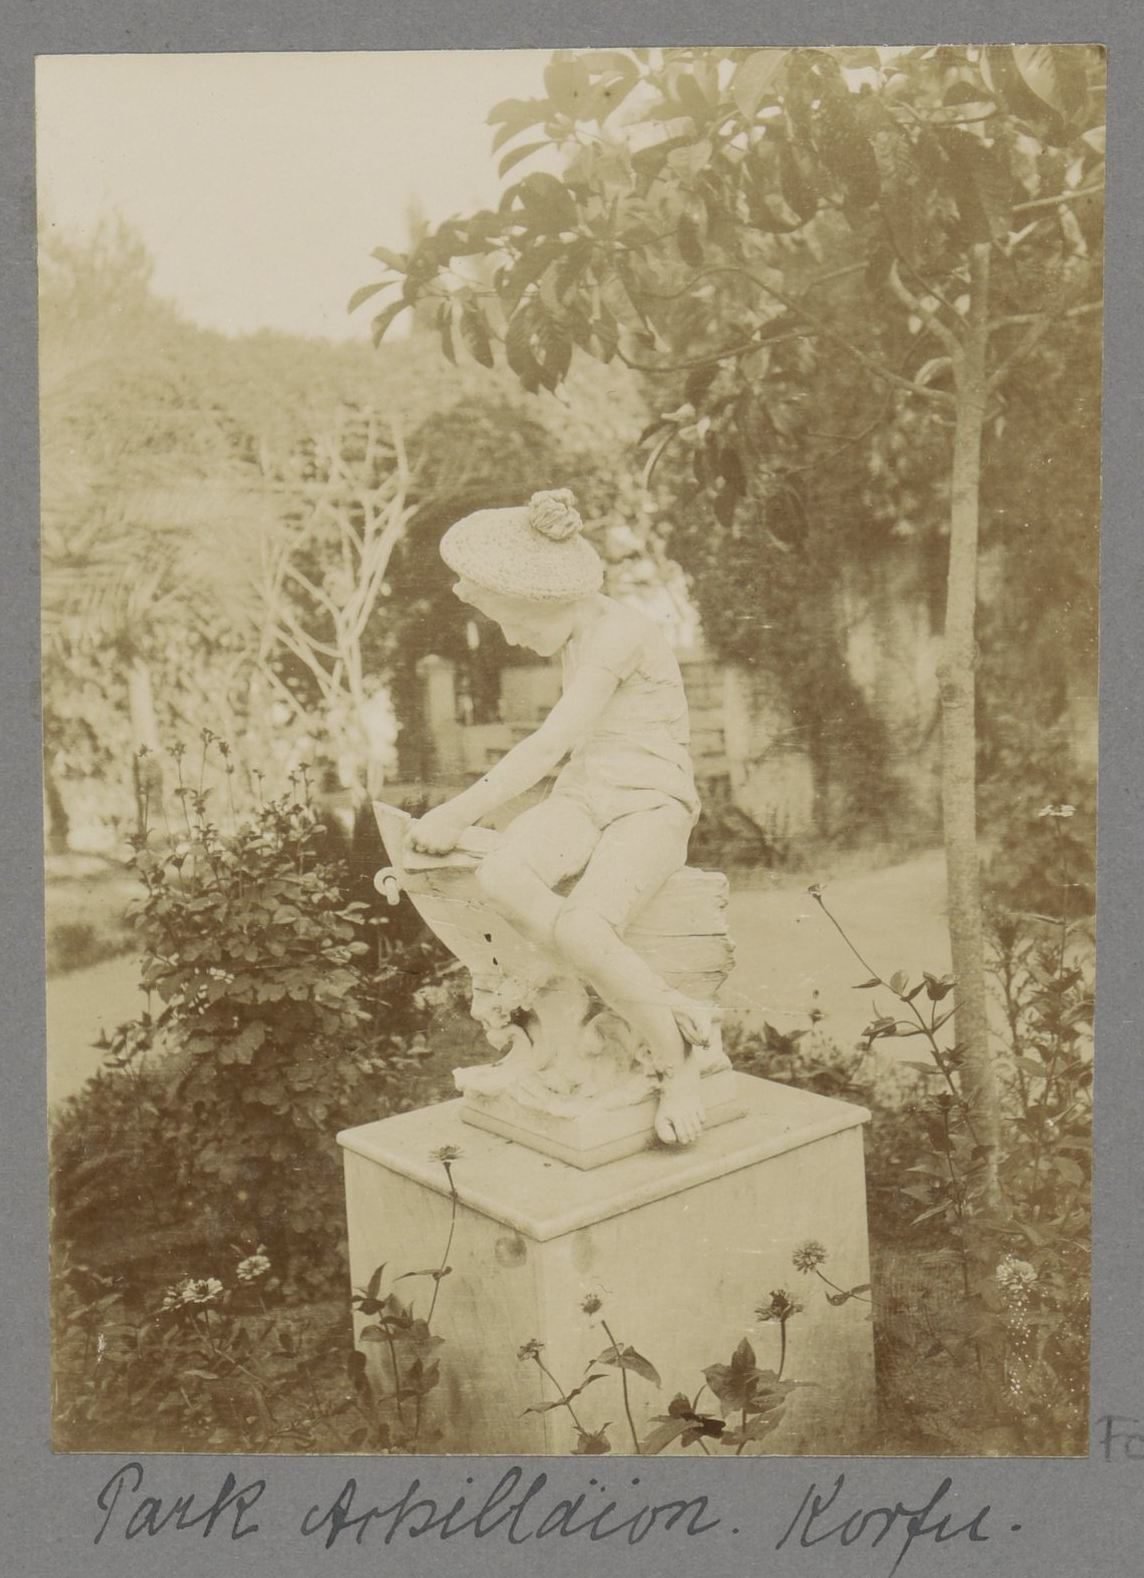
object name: album leaf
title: Beeld in het park van het Achilleion op Corfu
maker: Anonymous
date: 1905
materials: paper, photographic support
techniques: gelatin silver print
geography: corfu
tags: piece of sculpture, reproduction of a piece of sculpture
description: Onderdeel van Reisalbum met foto's van bezienswaardigheden in Griekenland en Egypte.